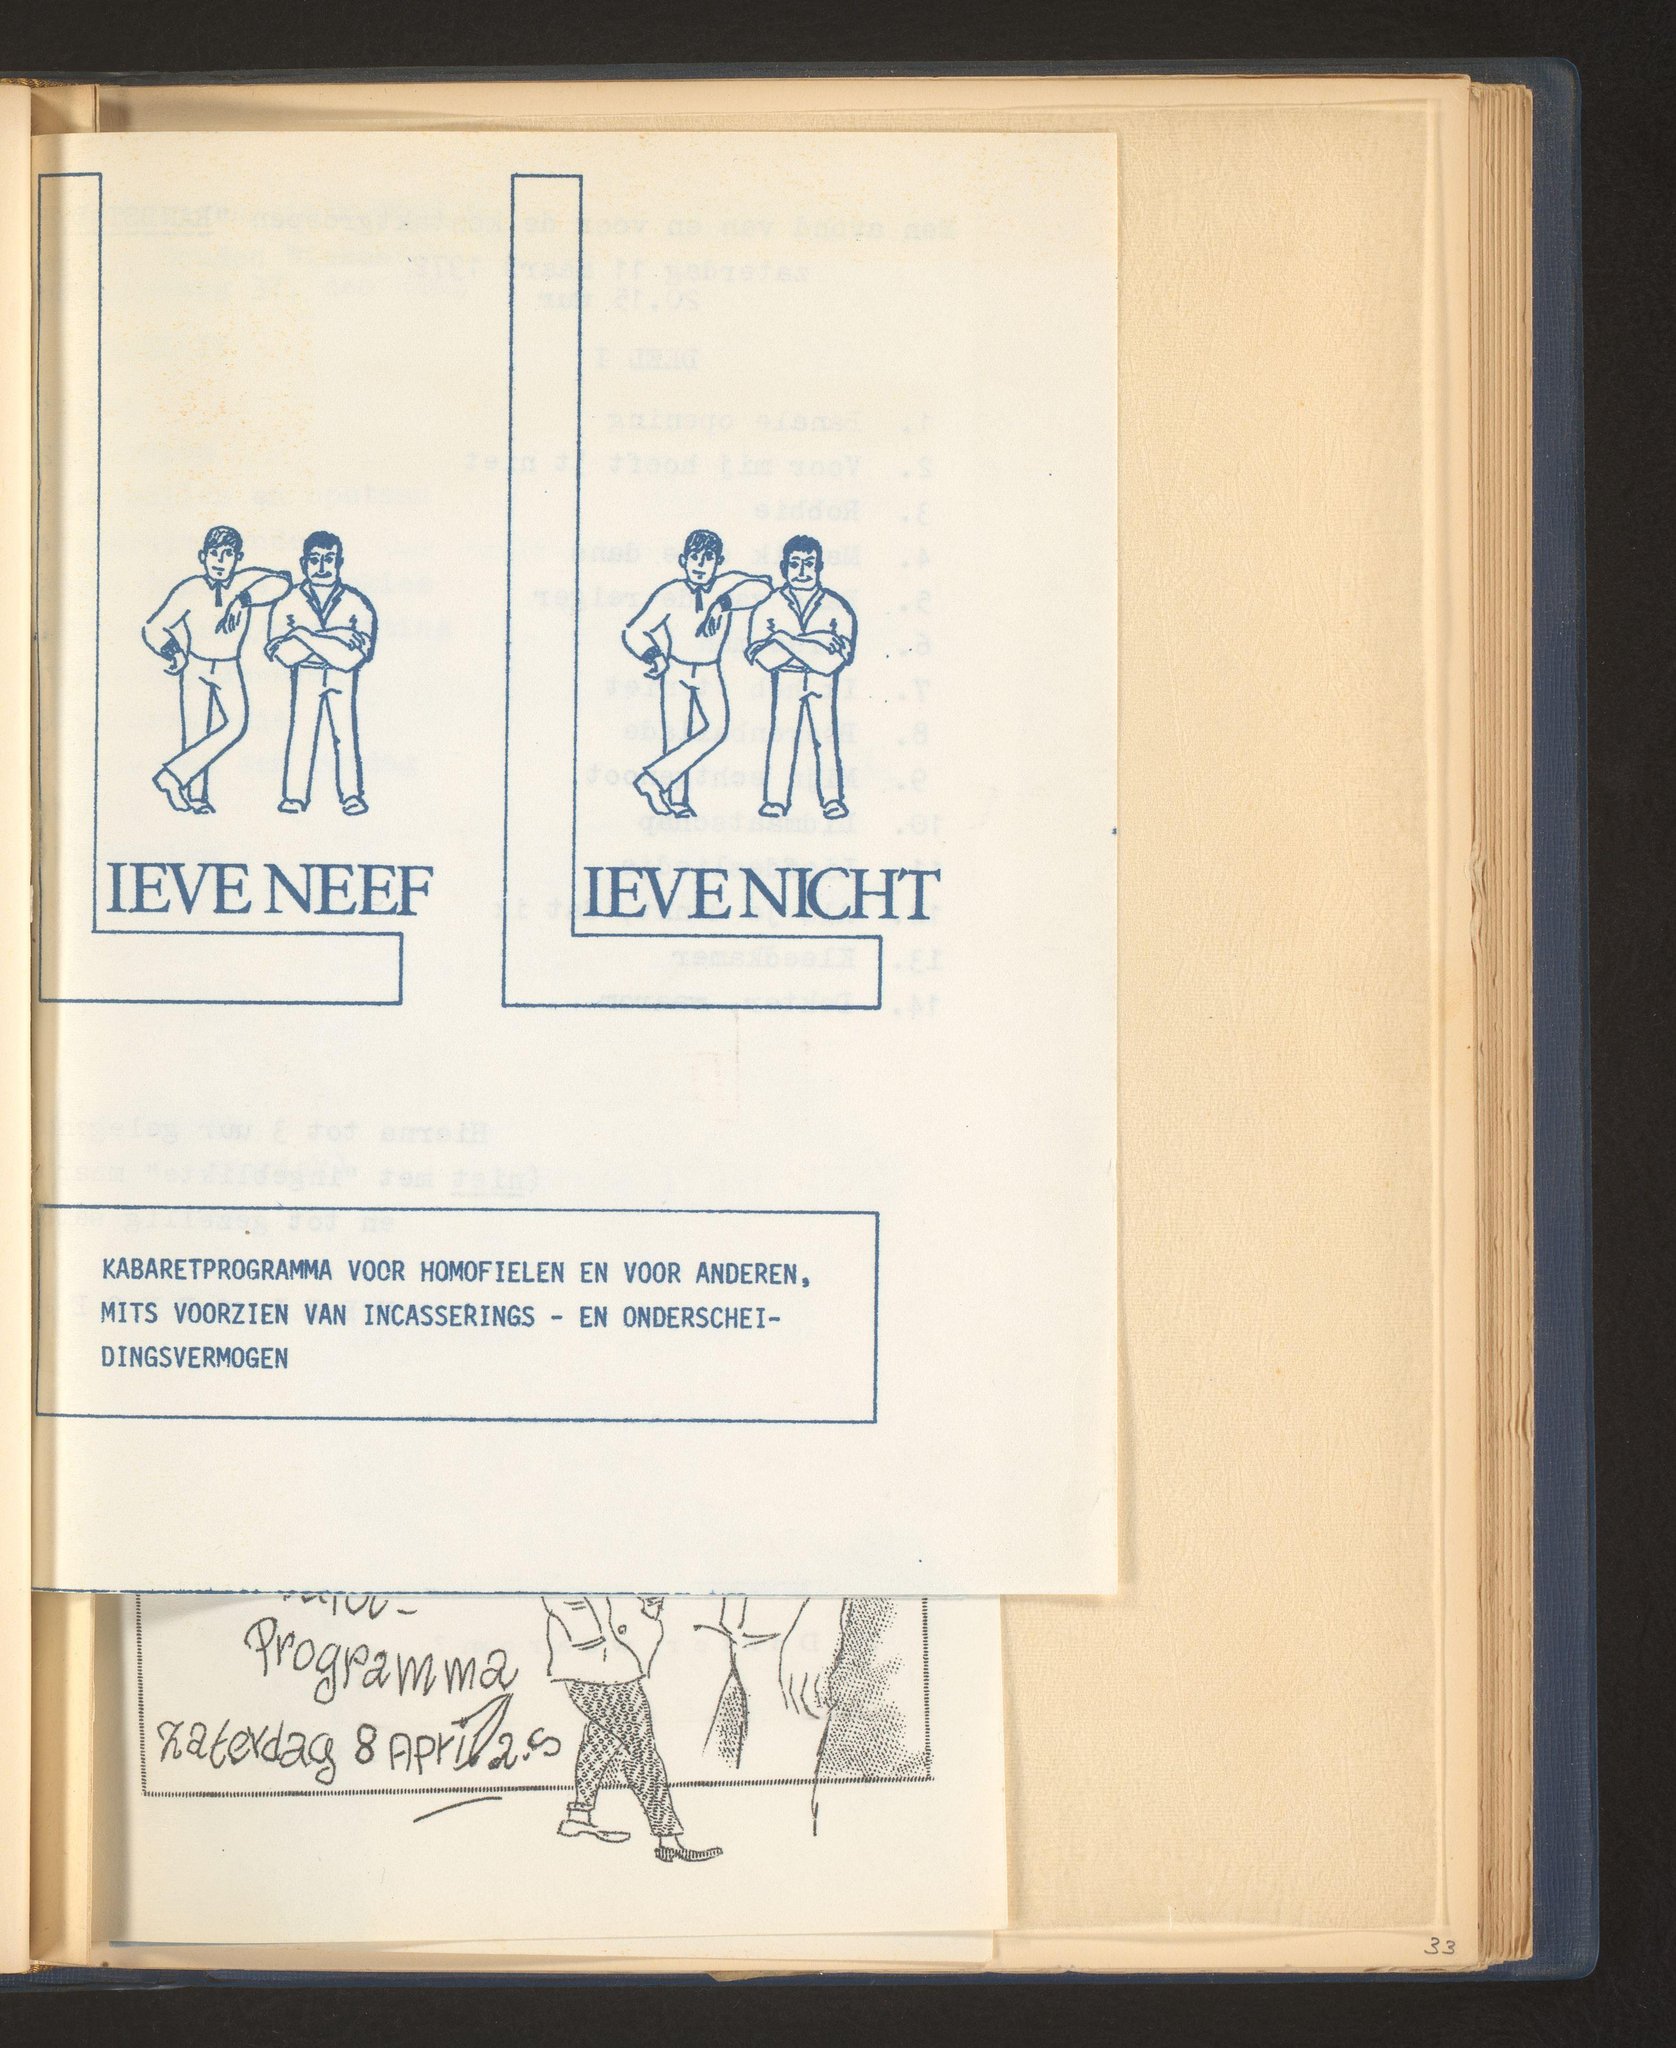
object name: programma, programmaboekje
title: Programma voor de cabaretvoorstelling 'Lieve Neef - Lieve Nicht' verzorgd door leden van het COC afdeling Den Haag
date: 1972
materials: cardboard, paper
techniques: printed materials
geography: the hague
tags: the hague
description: Tussen de albumbladen geplakt het (dubbelgevouwen) programma voor een uitvoering op 11 maart 1972 van het cabaretvoorstelling 'Lieve Neef - Lieve Nicht', verzorgd door leden van het COC afdeling Den Haag, in het gebouw "Op Gouden Wieken" te Den Haag. Onderdeel van het fotoalbum van cabaretvoorstellingen COC 1968-1974, afdeling Den Haag.